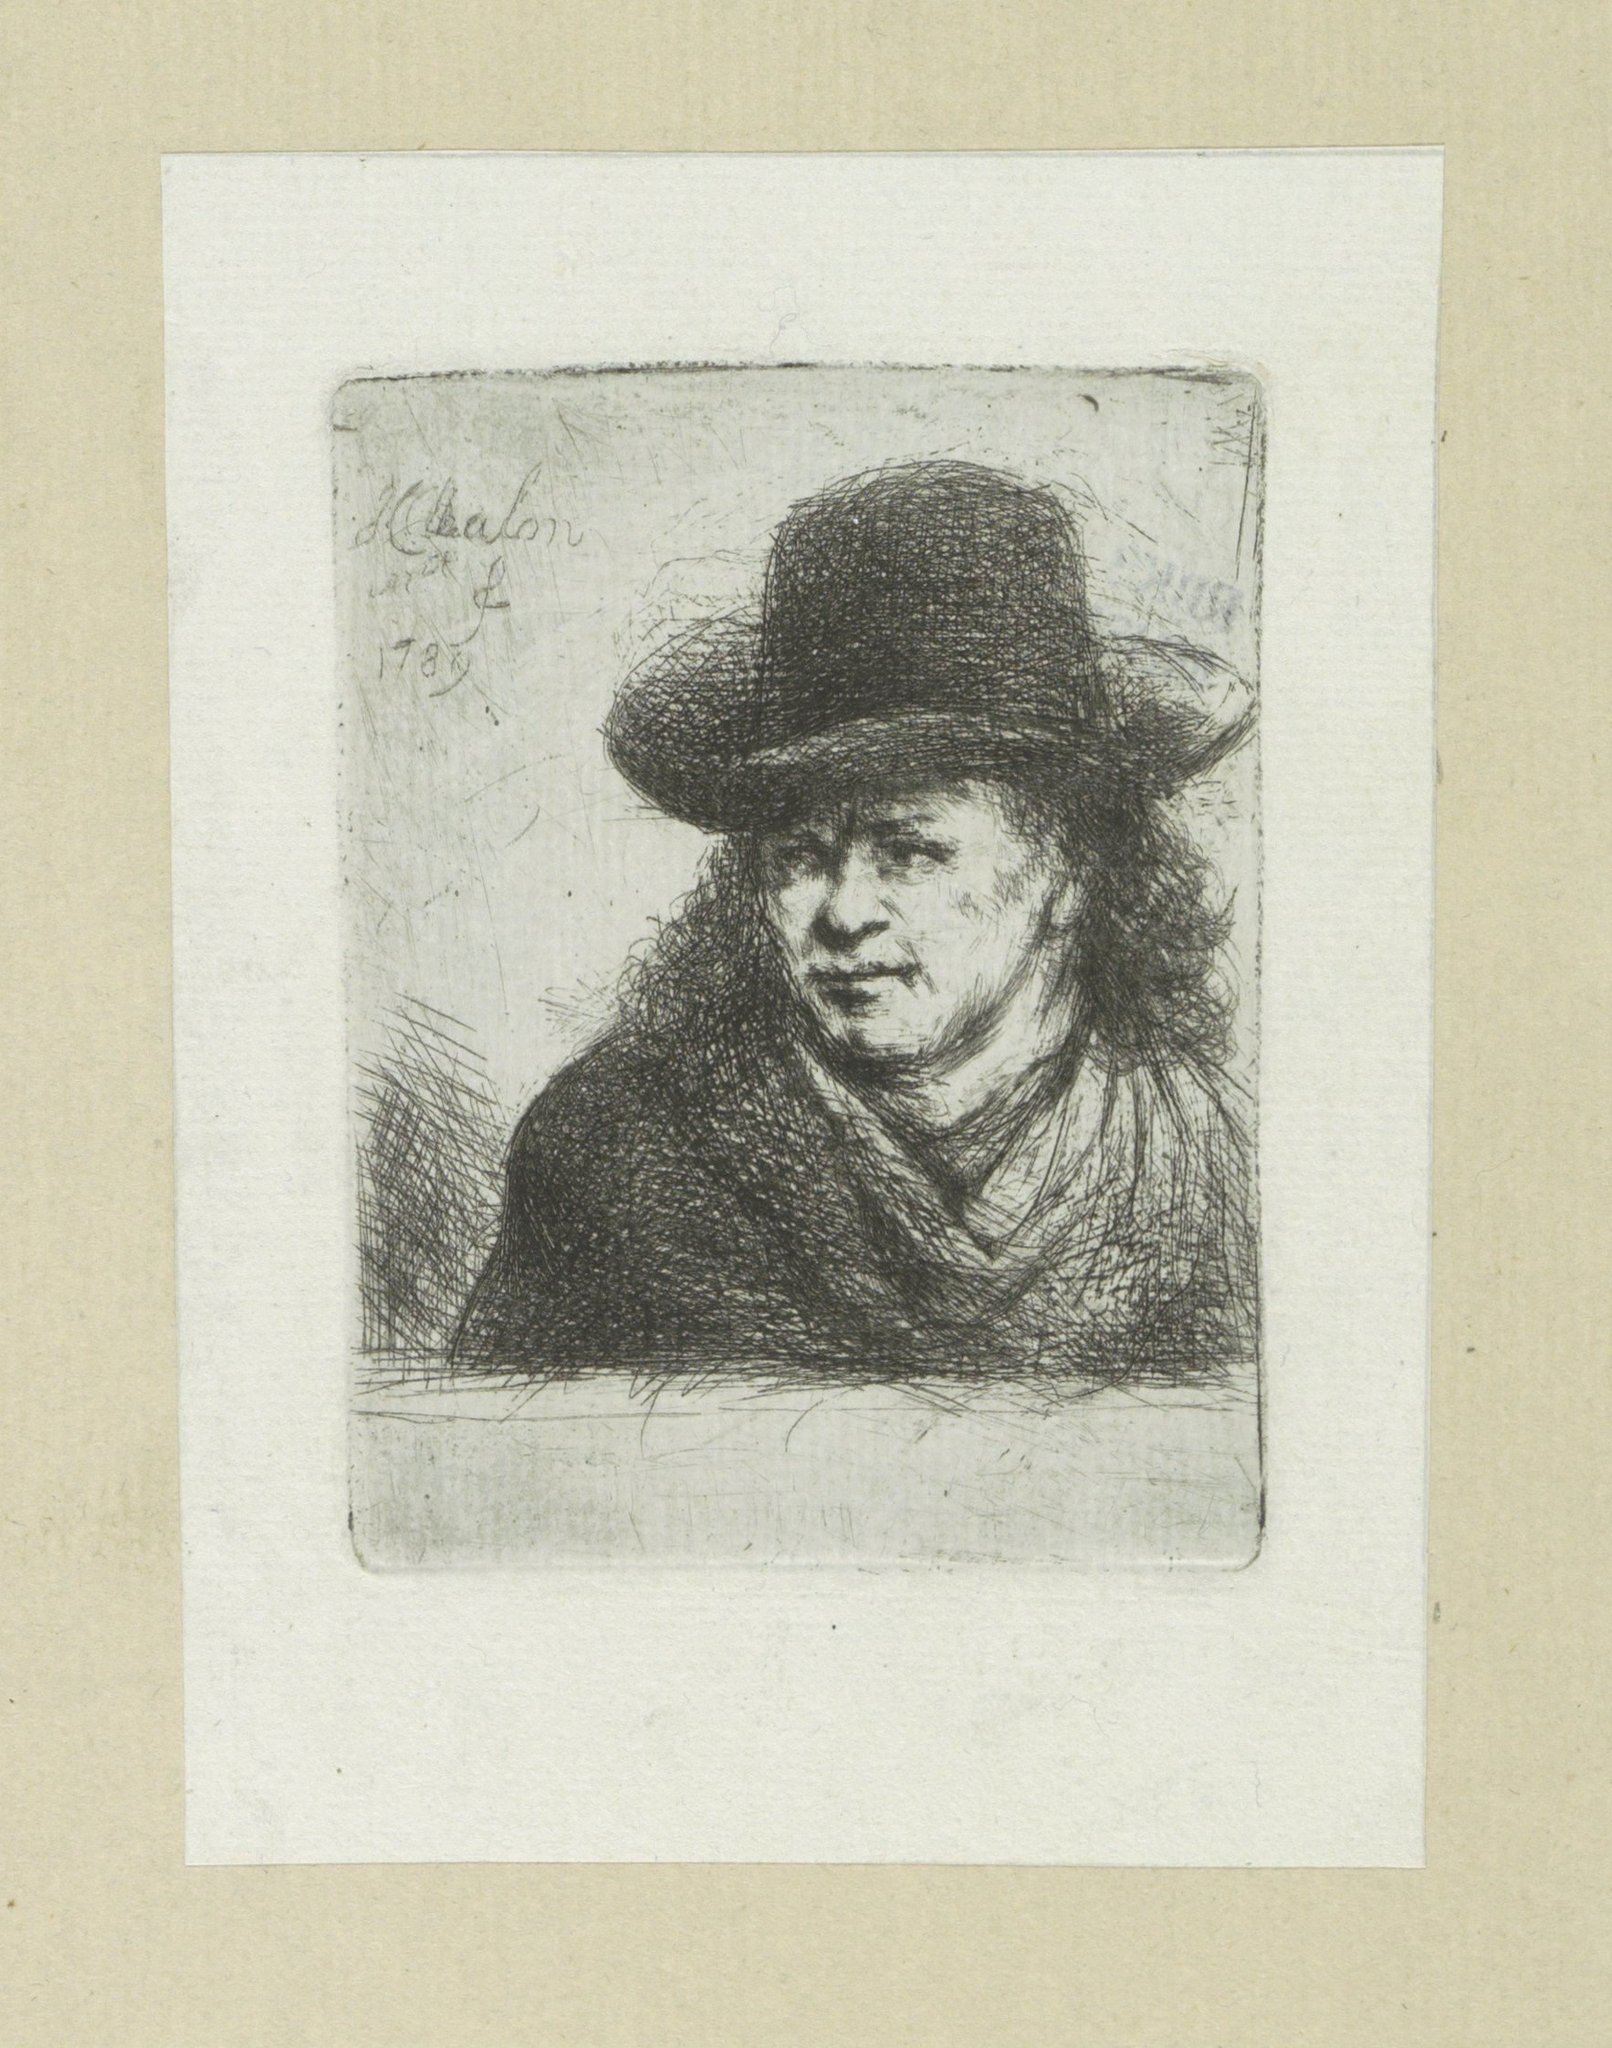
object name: print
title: The Compleat Work of Etchings by John Chalon / Oeuvre Complette des Eaux Fortes par Jean Chalon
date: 1789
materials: paper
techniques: drypoint, etching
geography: london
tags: head-gear: hat (+ men's clothes), morphology of human expression (+ old male (human being))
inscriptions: collector's mark: ‘RIJKS / MUSM’, collector's mark: ‘B’